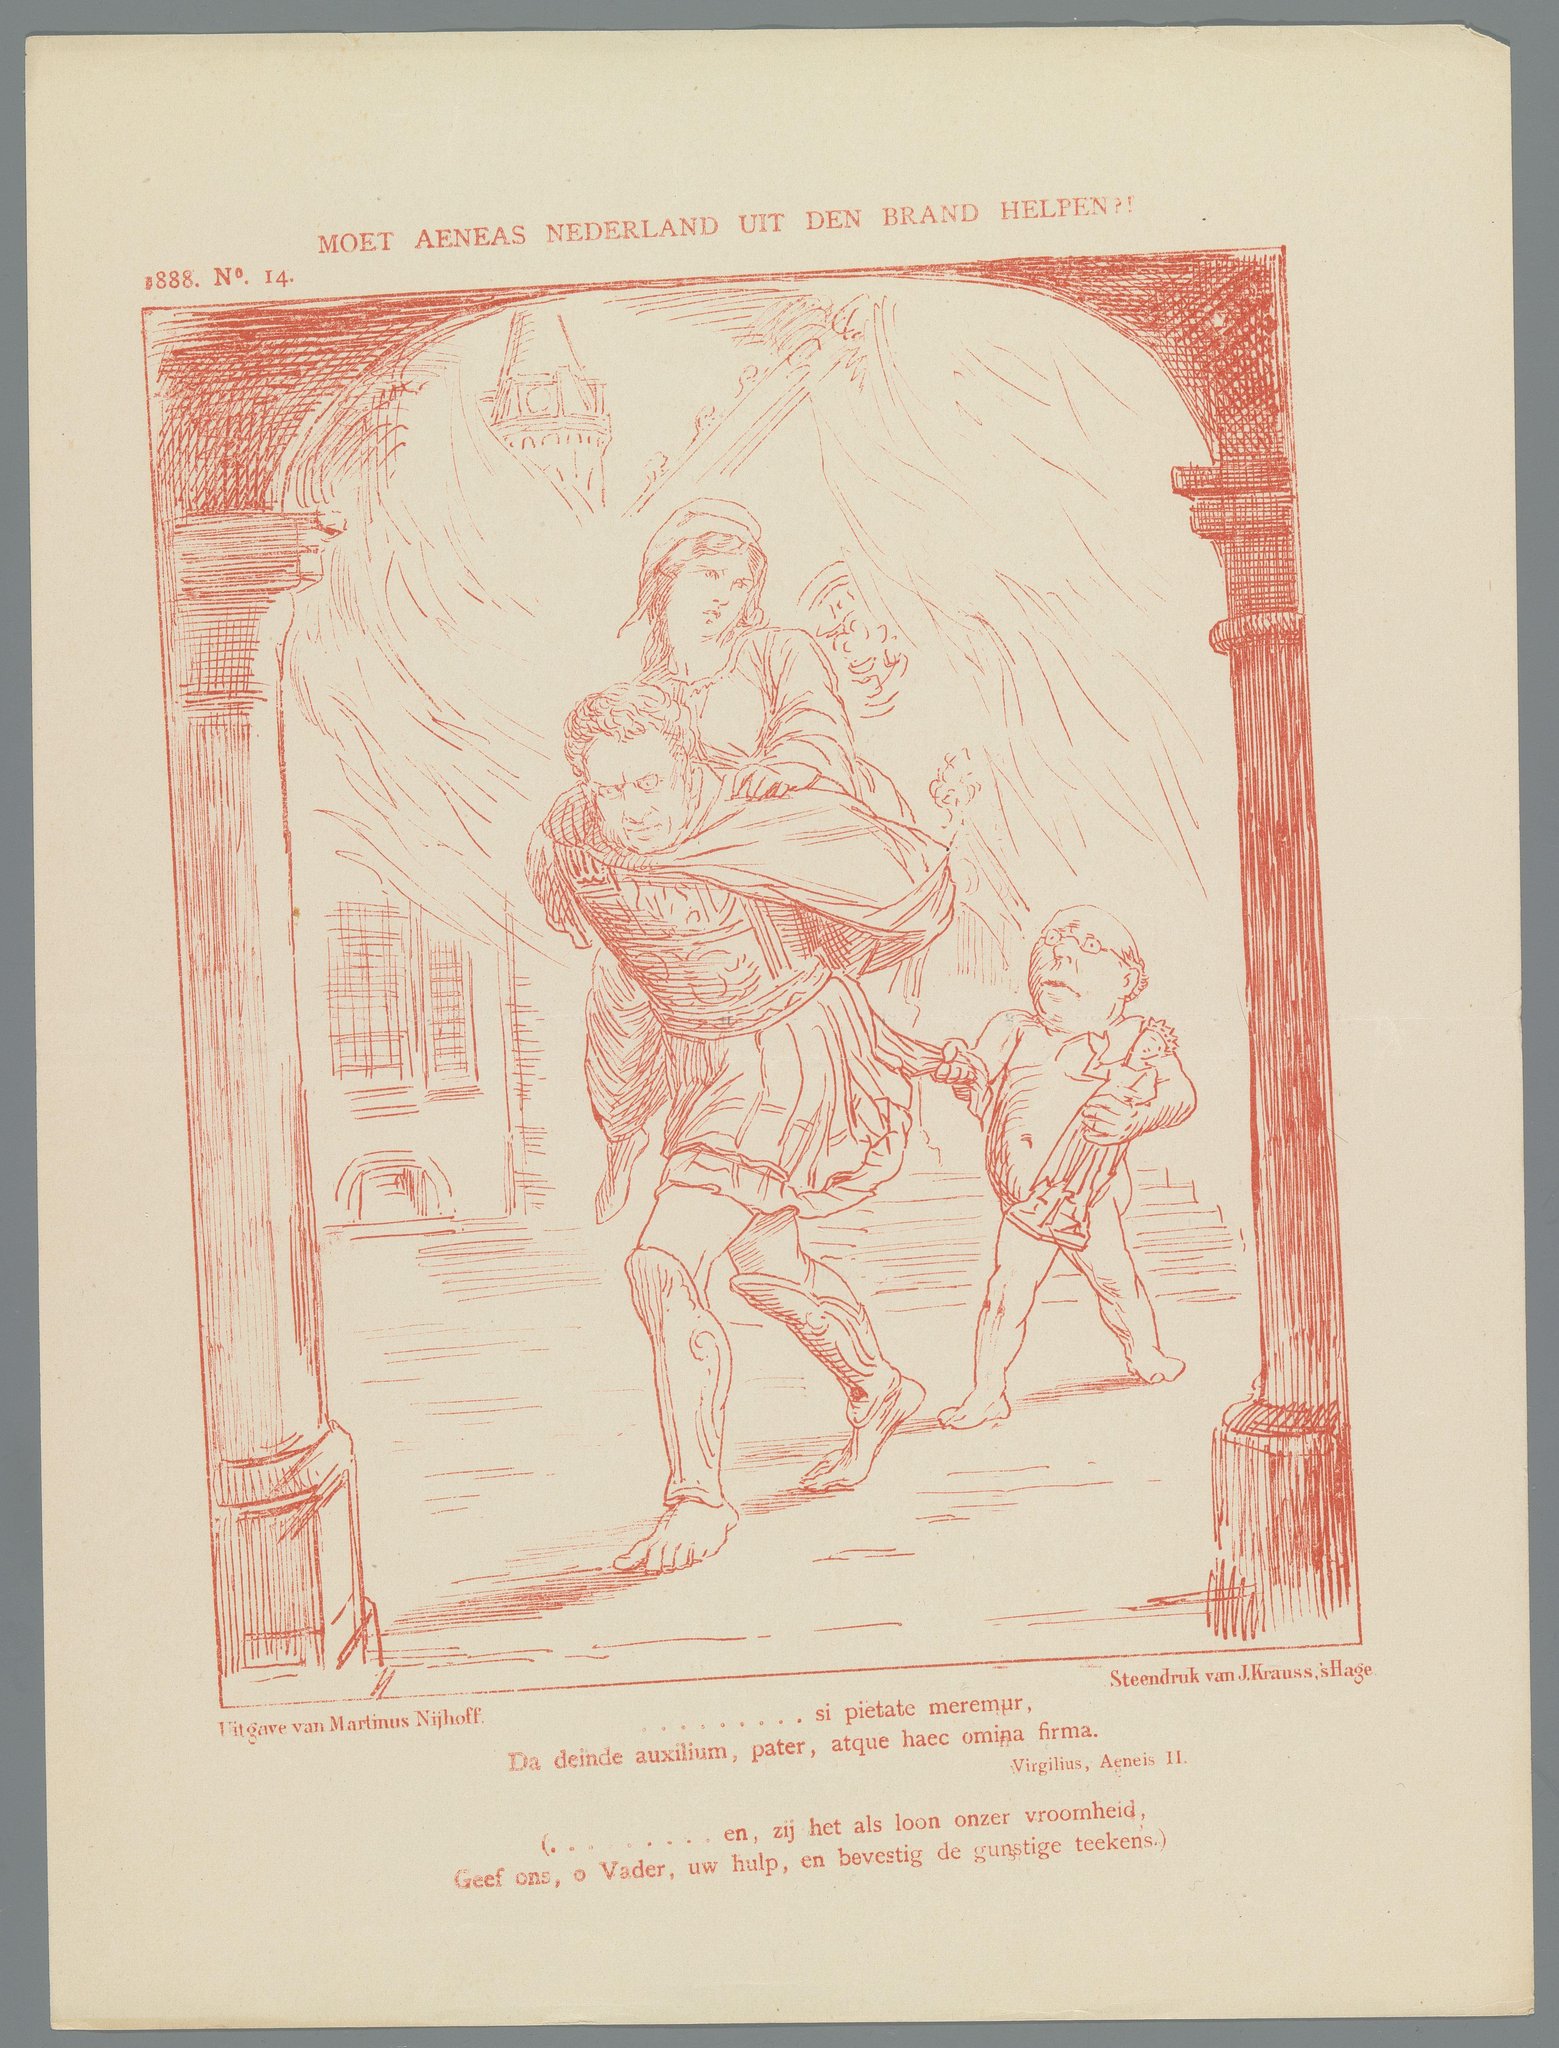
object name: print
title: Moet Aeneas Nederland uit den brand helpen?!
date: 1888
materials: paper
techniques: lithograph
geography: the hague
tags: amsterdam, the hague, politician, personifications of countries, nations, states, districts, etc.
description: Spotprent met minister Heemskerk als Aeneas met de Nederlandse Maagd op de rug. Plaat verschenen bij het weekblad De Nederlandsche Spectator, nr. 14, 1888.